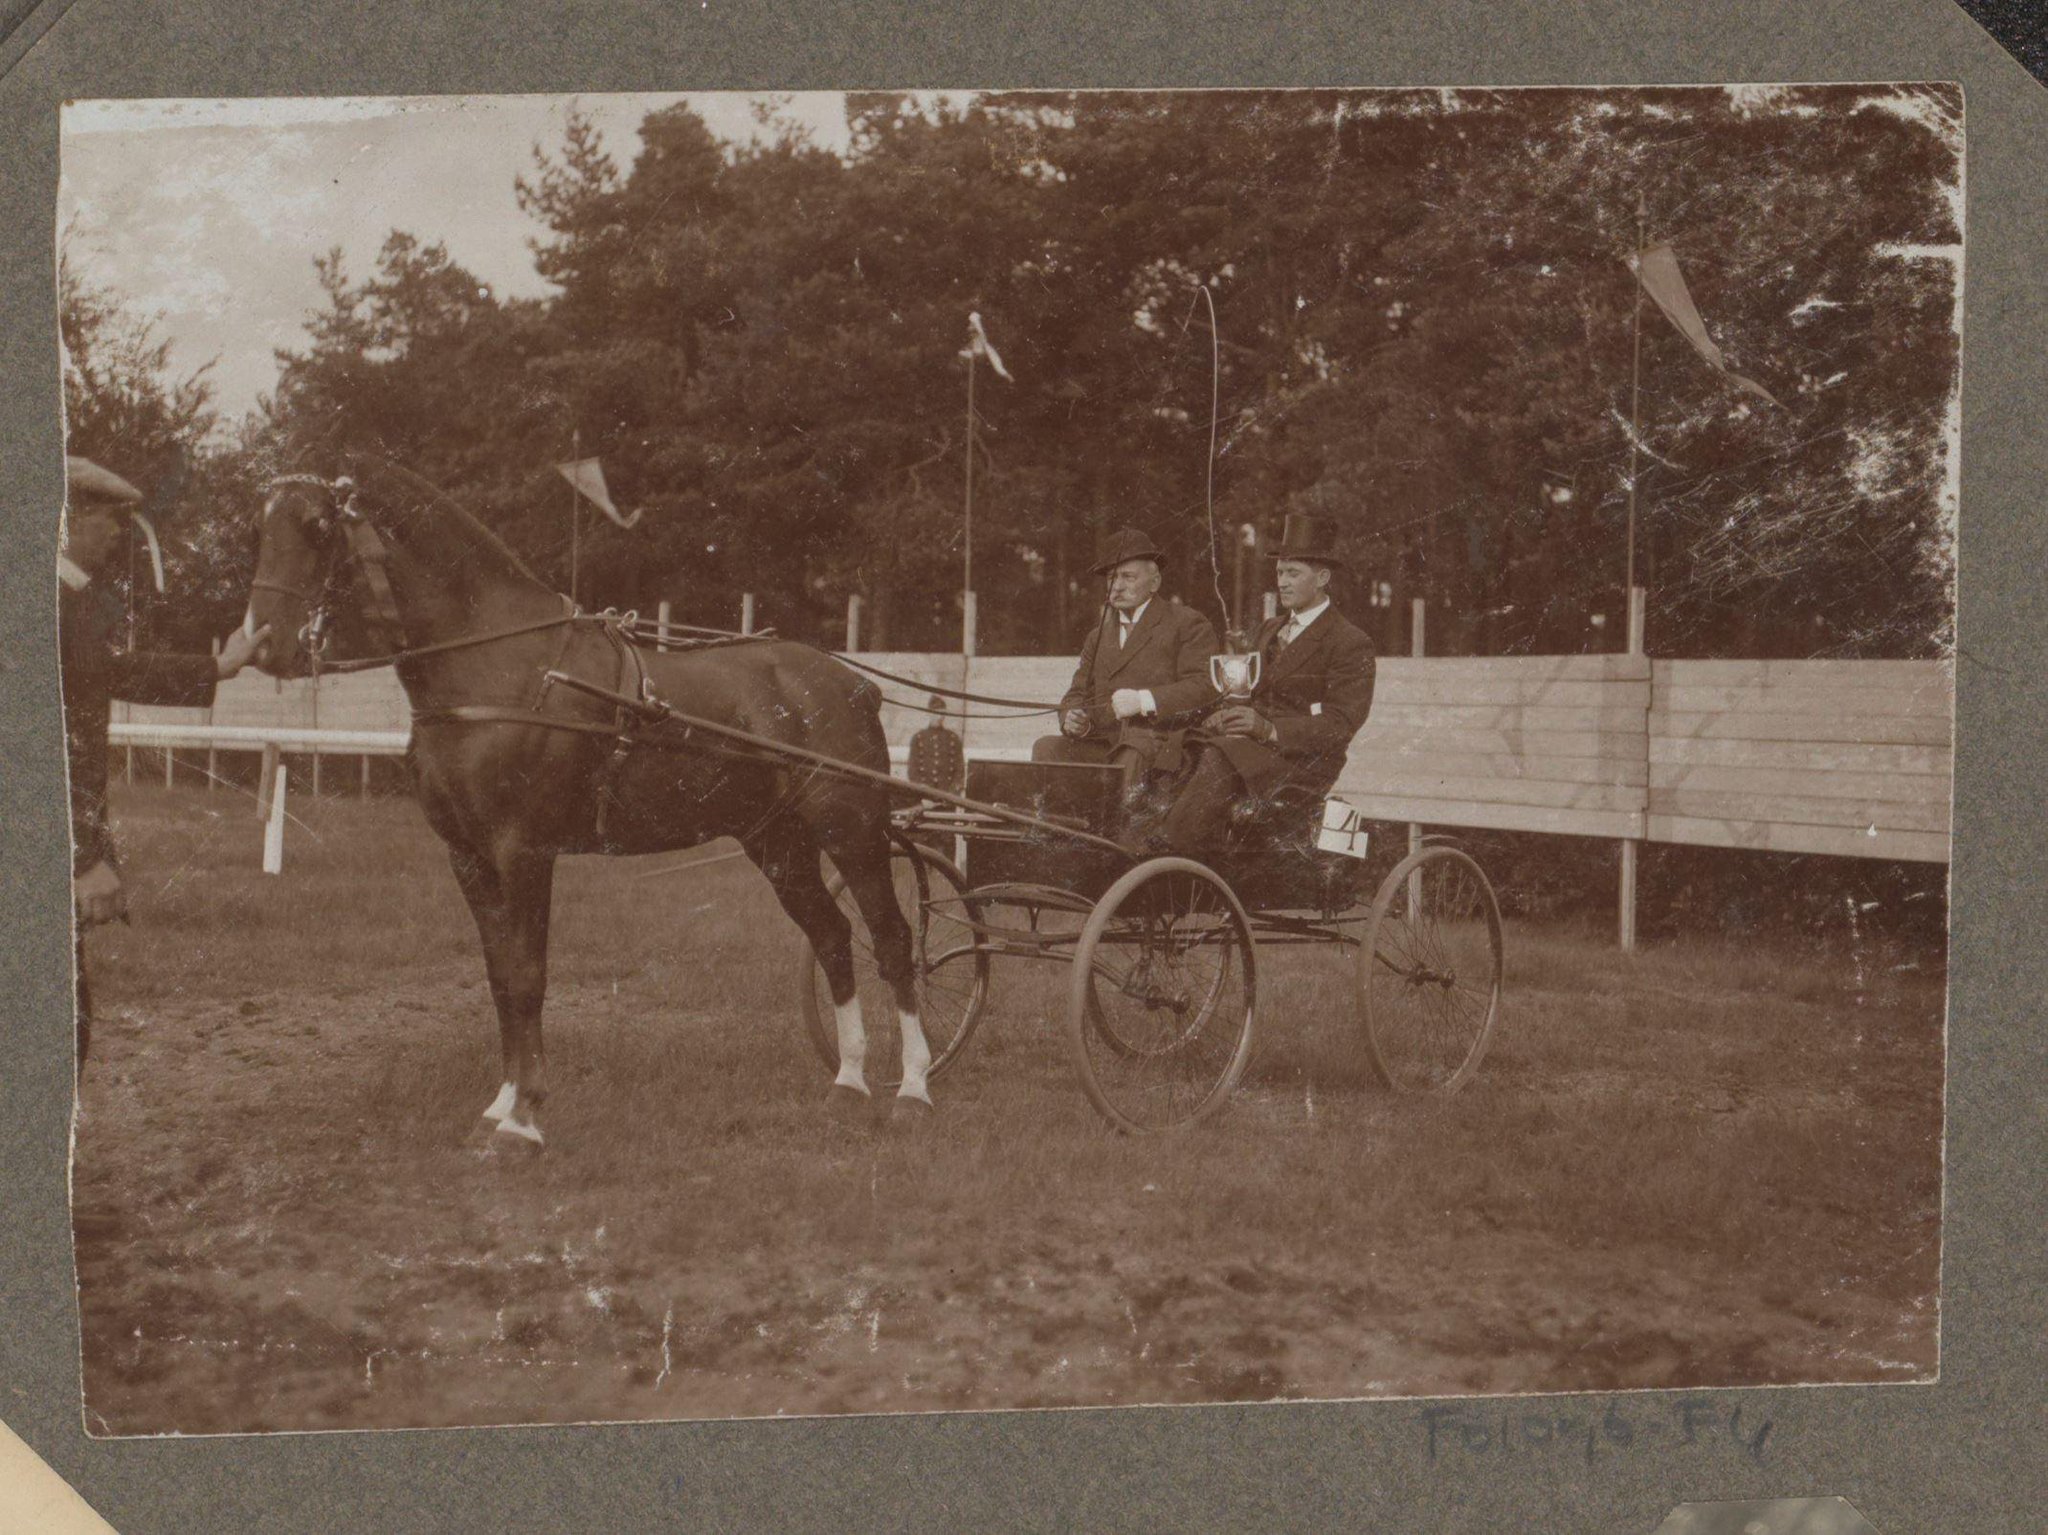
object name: album leaf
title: Ruitertafereel op Koninklijke Houtvesterij Het Loo: genummerd tweepersoons paardenrijtuig op een grasveld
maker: Anonymous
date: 1900-1925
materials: photographic support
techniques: gelatin silver print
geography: het loo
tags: hunting, chase, hunting-ground, four-wheeled, animal-drawn vehicle, e.g.: cab, carriage, coach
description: Onderdeel van Fotoalbum van de heer Brams, opperhoutvester van koningin Wilhelmina op Koninklijke Houtvesterij Het Loo.